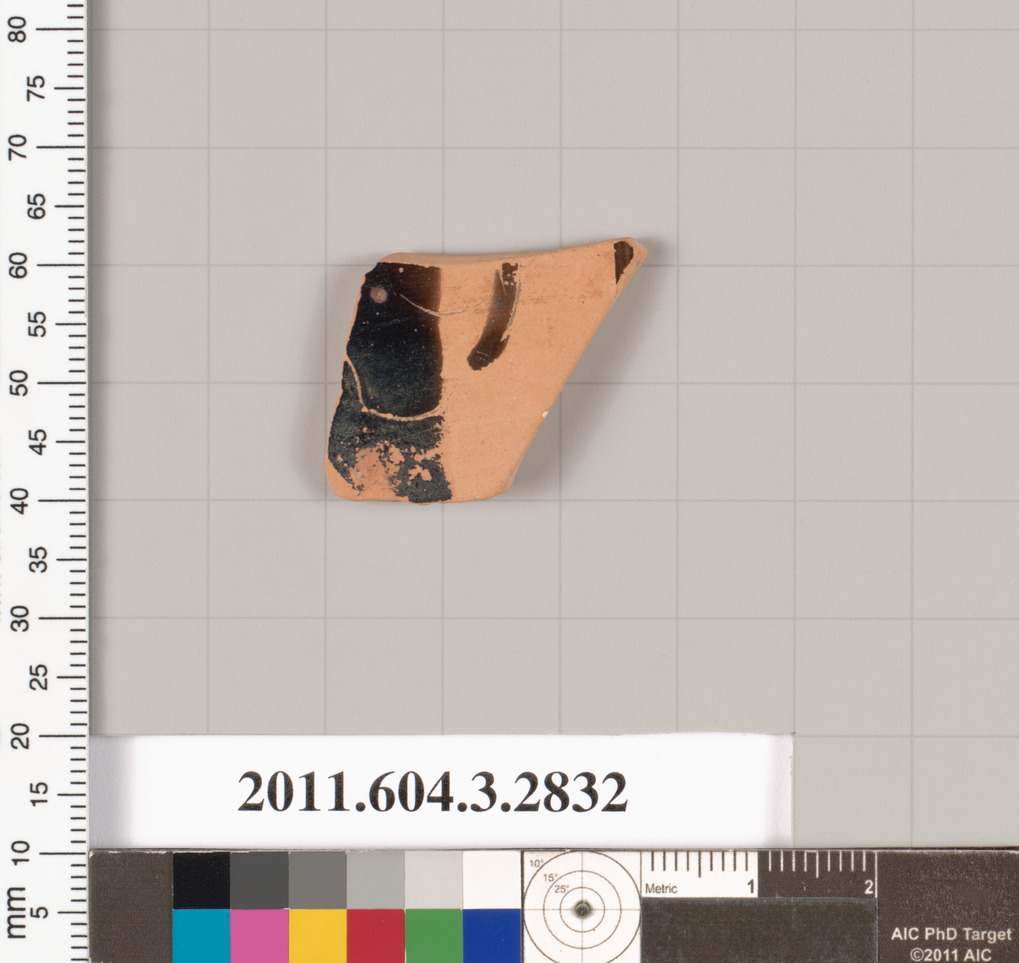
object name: undetermined closed shape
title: Terracotta fragment of a closed shape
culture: greek, attic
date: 534-468 BCE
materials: terracotta